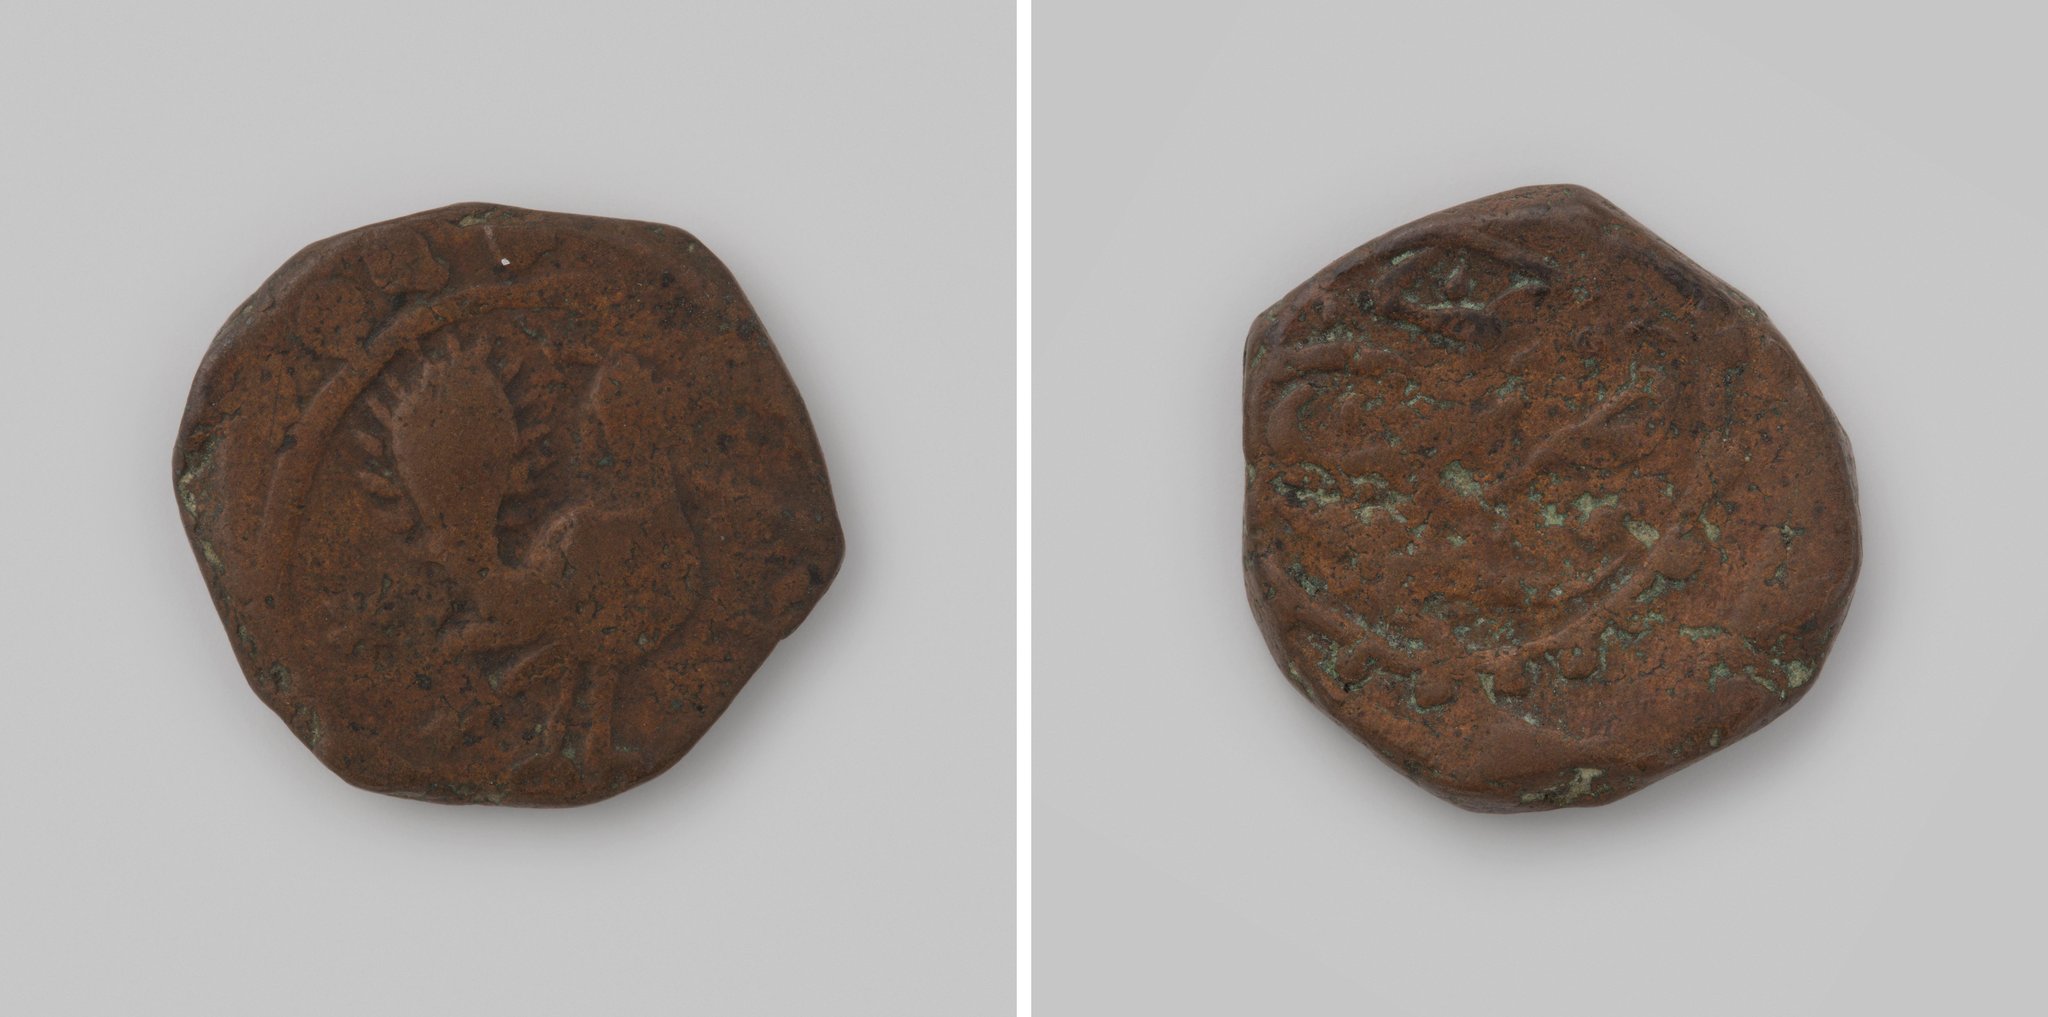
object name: coin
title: Perzië, ten tijde van sjah Hoesein, 1105-1135 [=1693-1722], falus,Tabriz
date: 1693-1722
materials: copper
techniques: striking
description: Koperen munt. Voorzijde: pauw met uitgespreide staart naar rechts, waaromheen versiering. Keerzijde: in Arabische lettertekens in drie regels muntplaats-aanduiding. Geslagen te Tabriz, keerzijde versprongen.